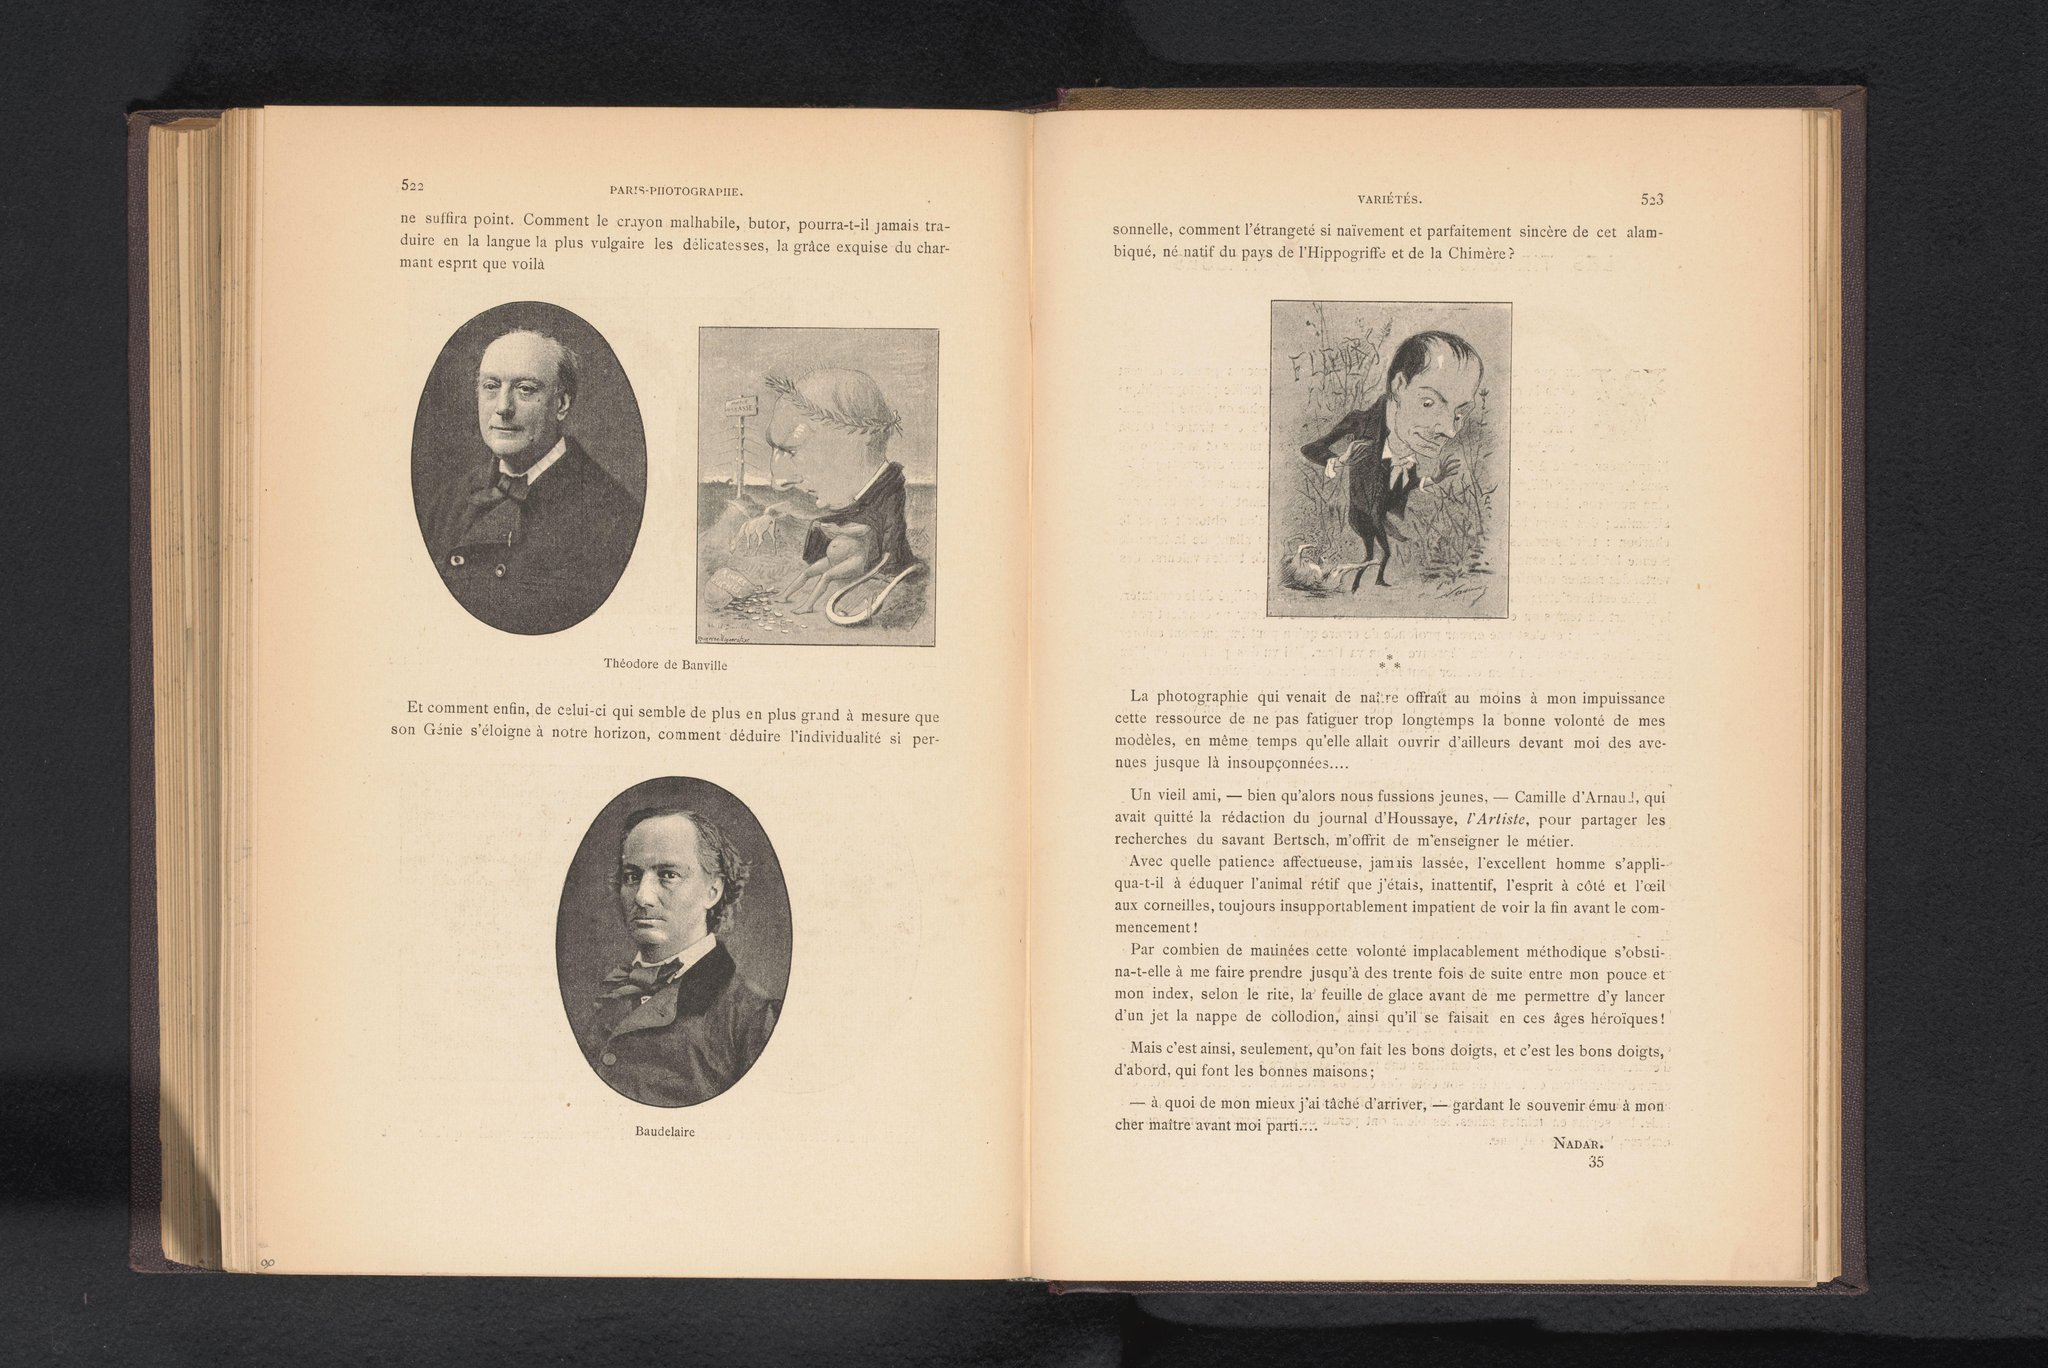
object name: photomechanical print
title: Théodore de Banville Baudelaire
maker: Anonymous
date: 1882-1892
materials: paper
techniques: autotype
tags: paris, charles baudelaire, caricatures (human types), portrait of a writer